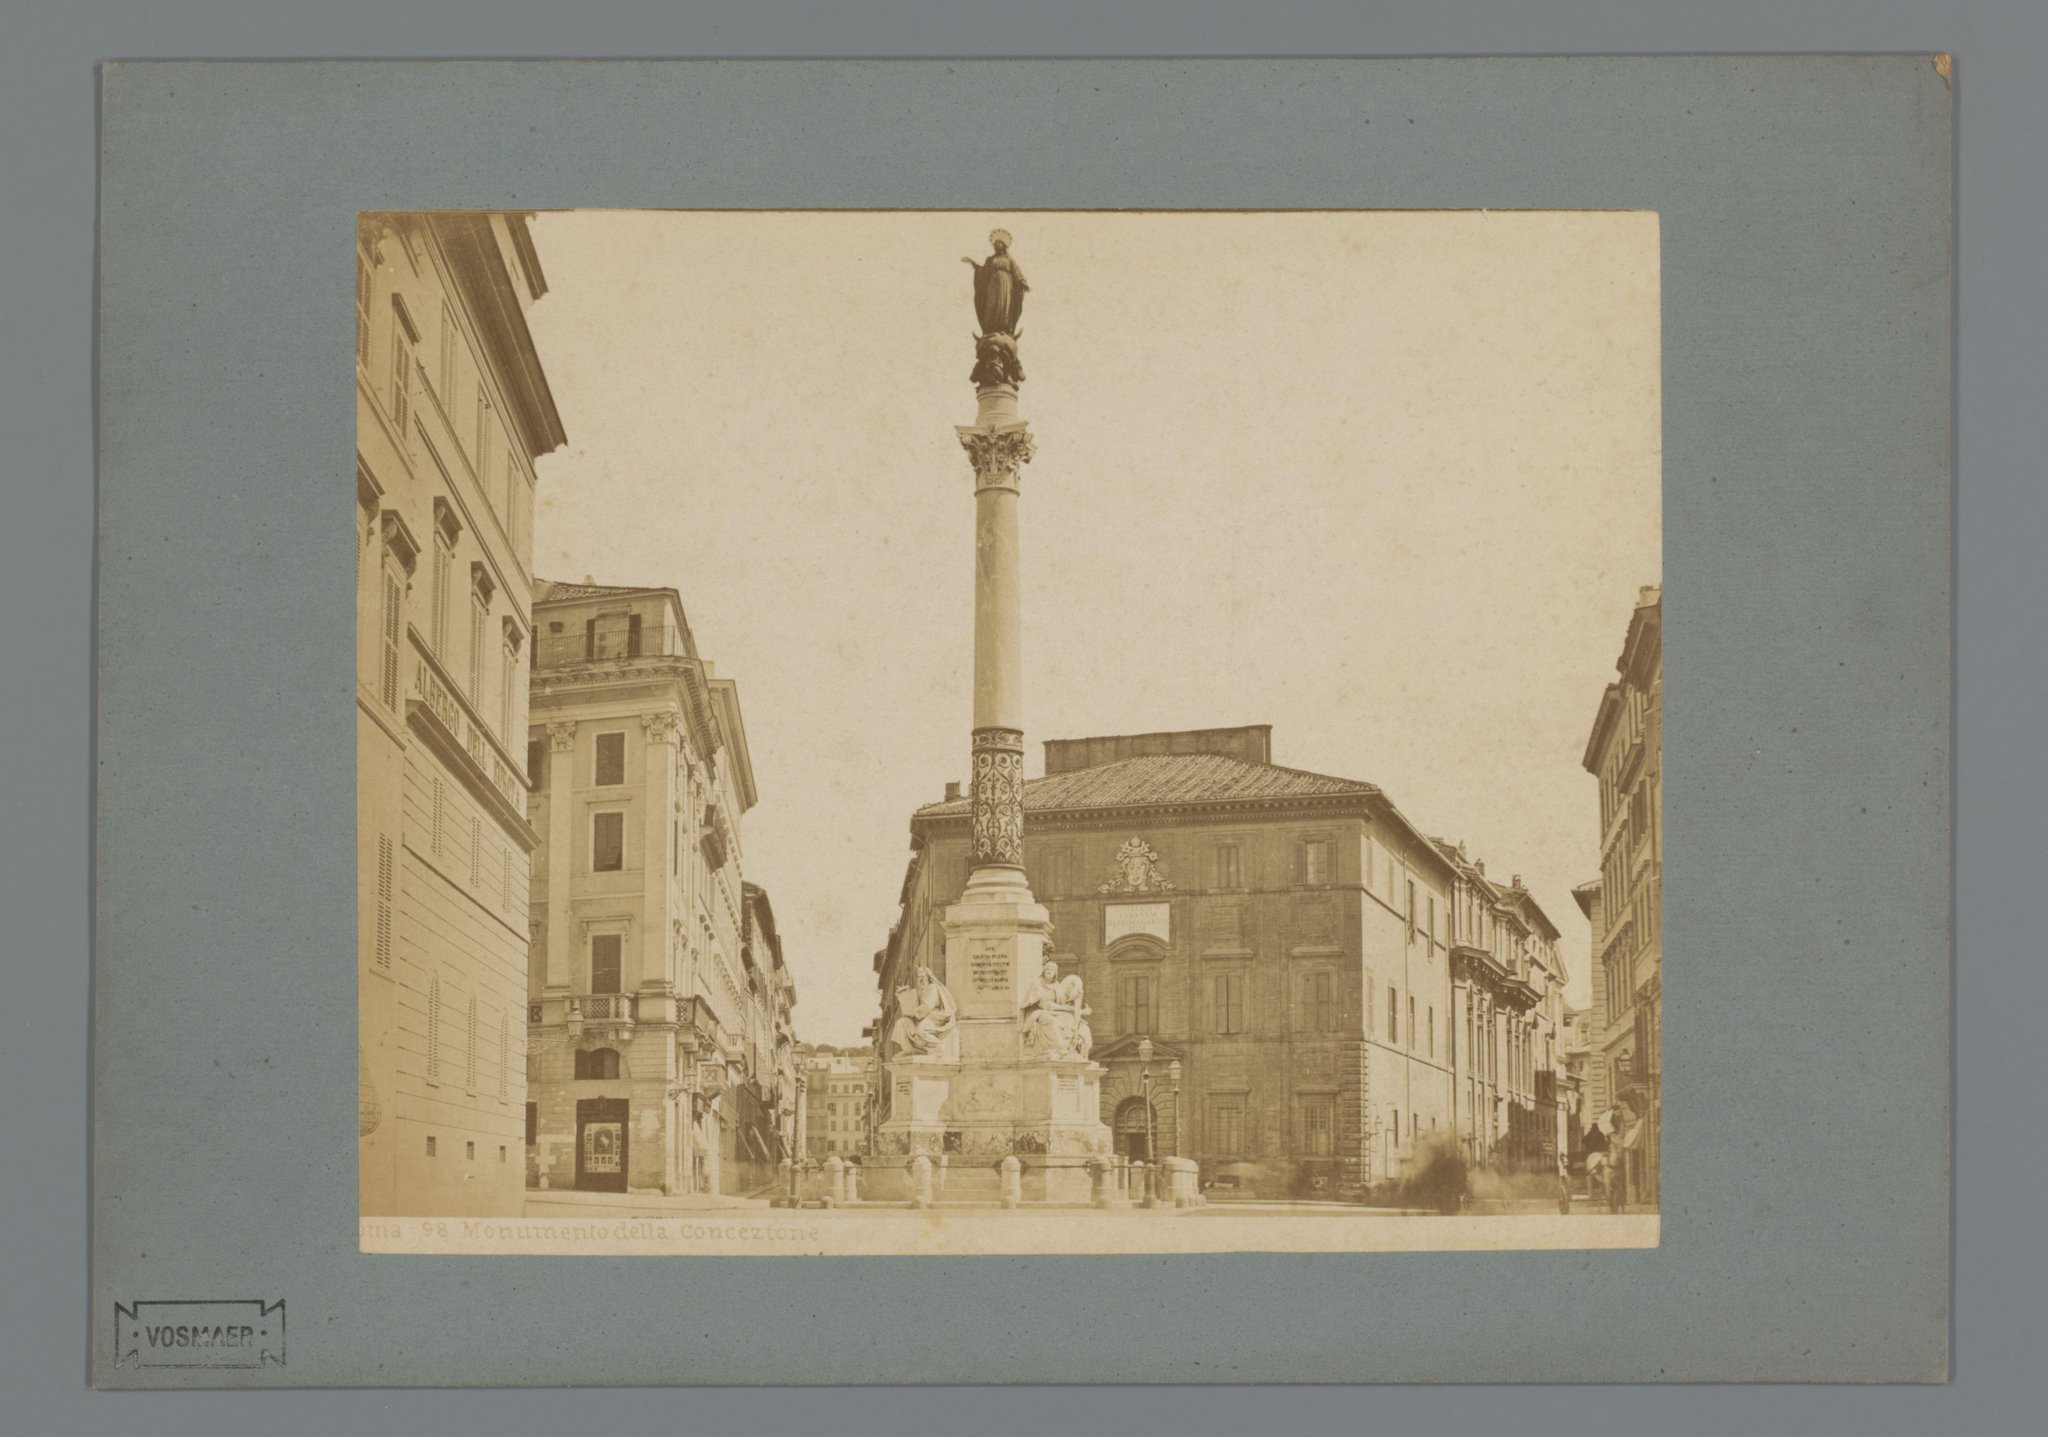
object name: photograph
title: Zuil van de Onbevlekte Ontvangenis op het Piazza Mignanelli te Rome, Italië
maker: Anonymous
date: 1851-1890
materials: cardboard, paper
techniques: albumen print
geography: rome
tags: square, place, circus, etc., obelisk, needle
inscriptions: collector's mark: ‘VOSMAER’, number: ‘98’